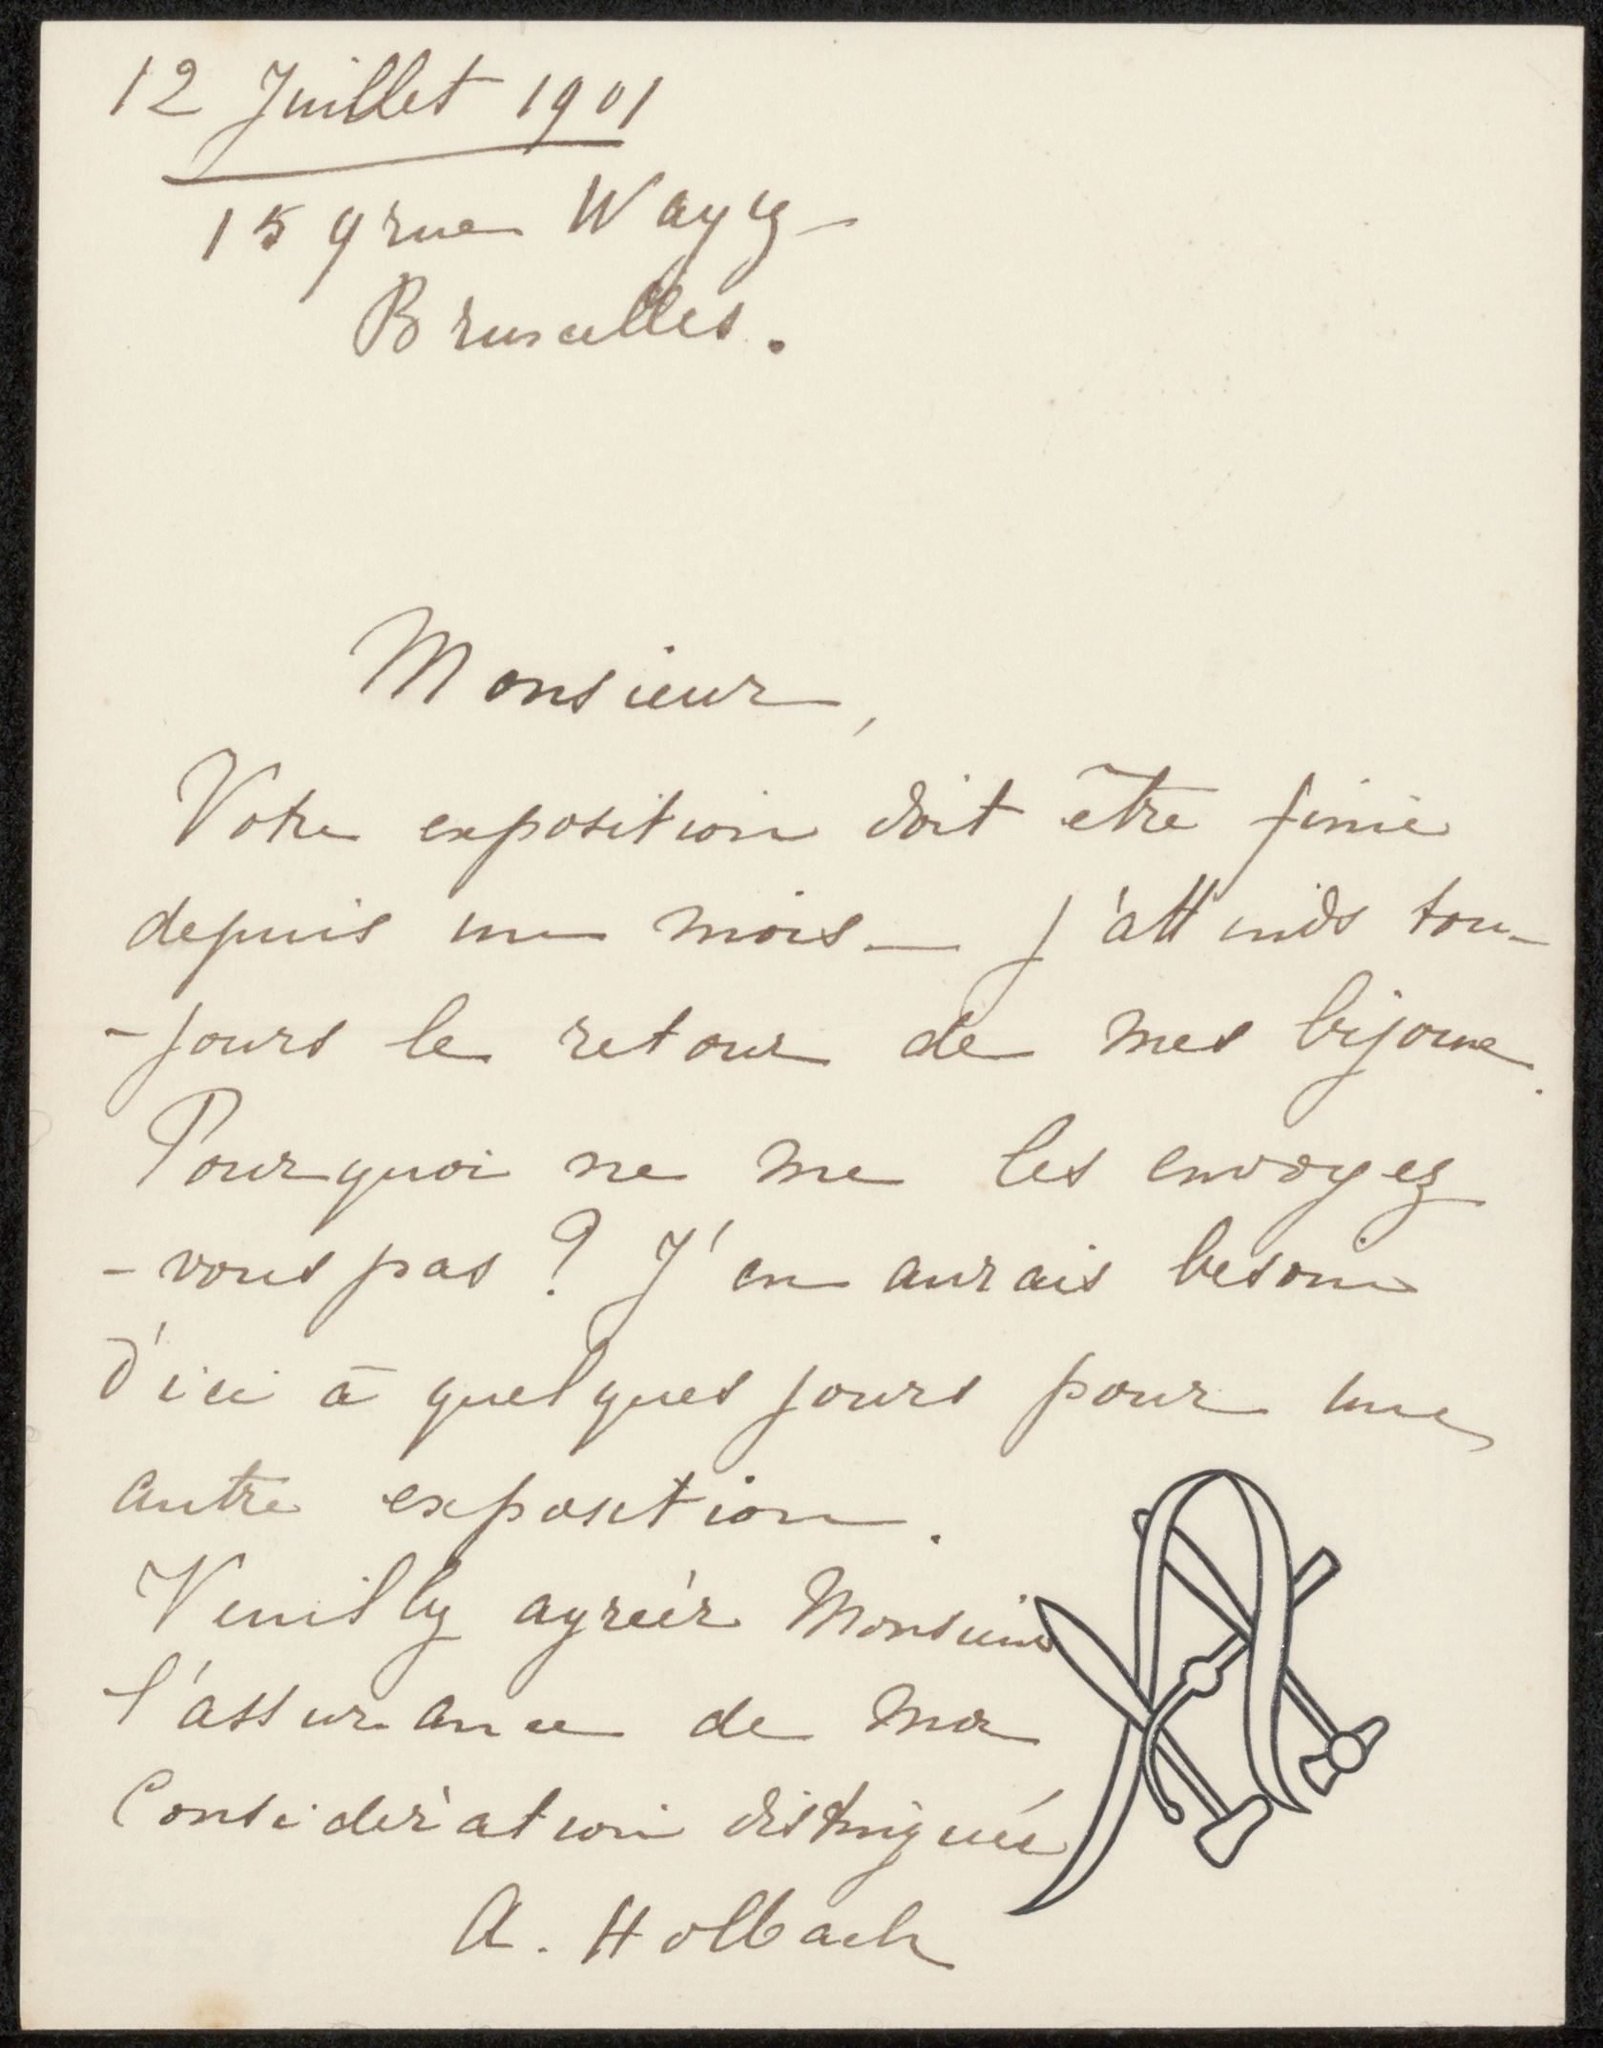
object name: letter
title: Brief aan Philip Zilcken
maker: alice holbach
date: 1901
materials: ink, paper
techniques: pen, printing, writing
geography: brussels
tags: the hague, painter, draughtsman, philip zilcken, temporary exhibition, 'salon'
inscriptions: watermark, collector's mark: ‘RPK’, monogram: ‘AH’